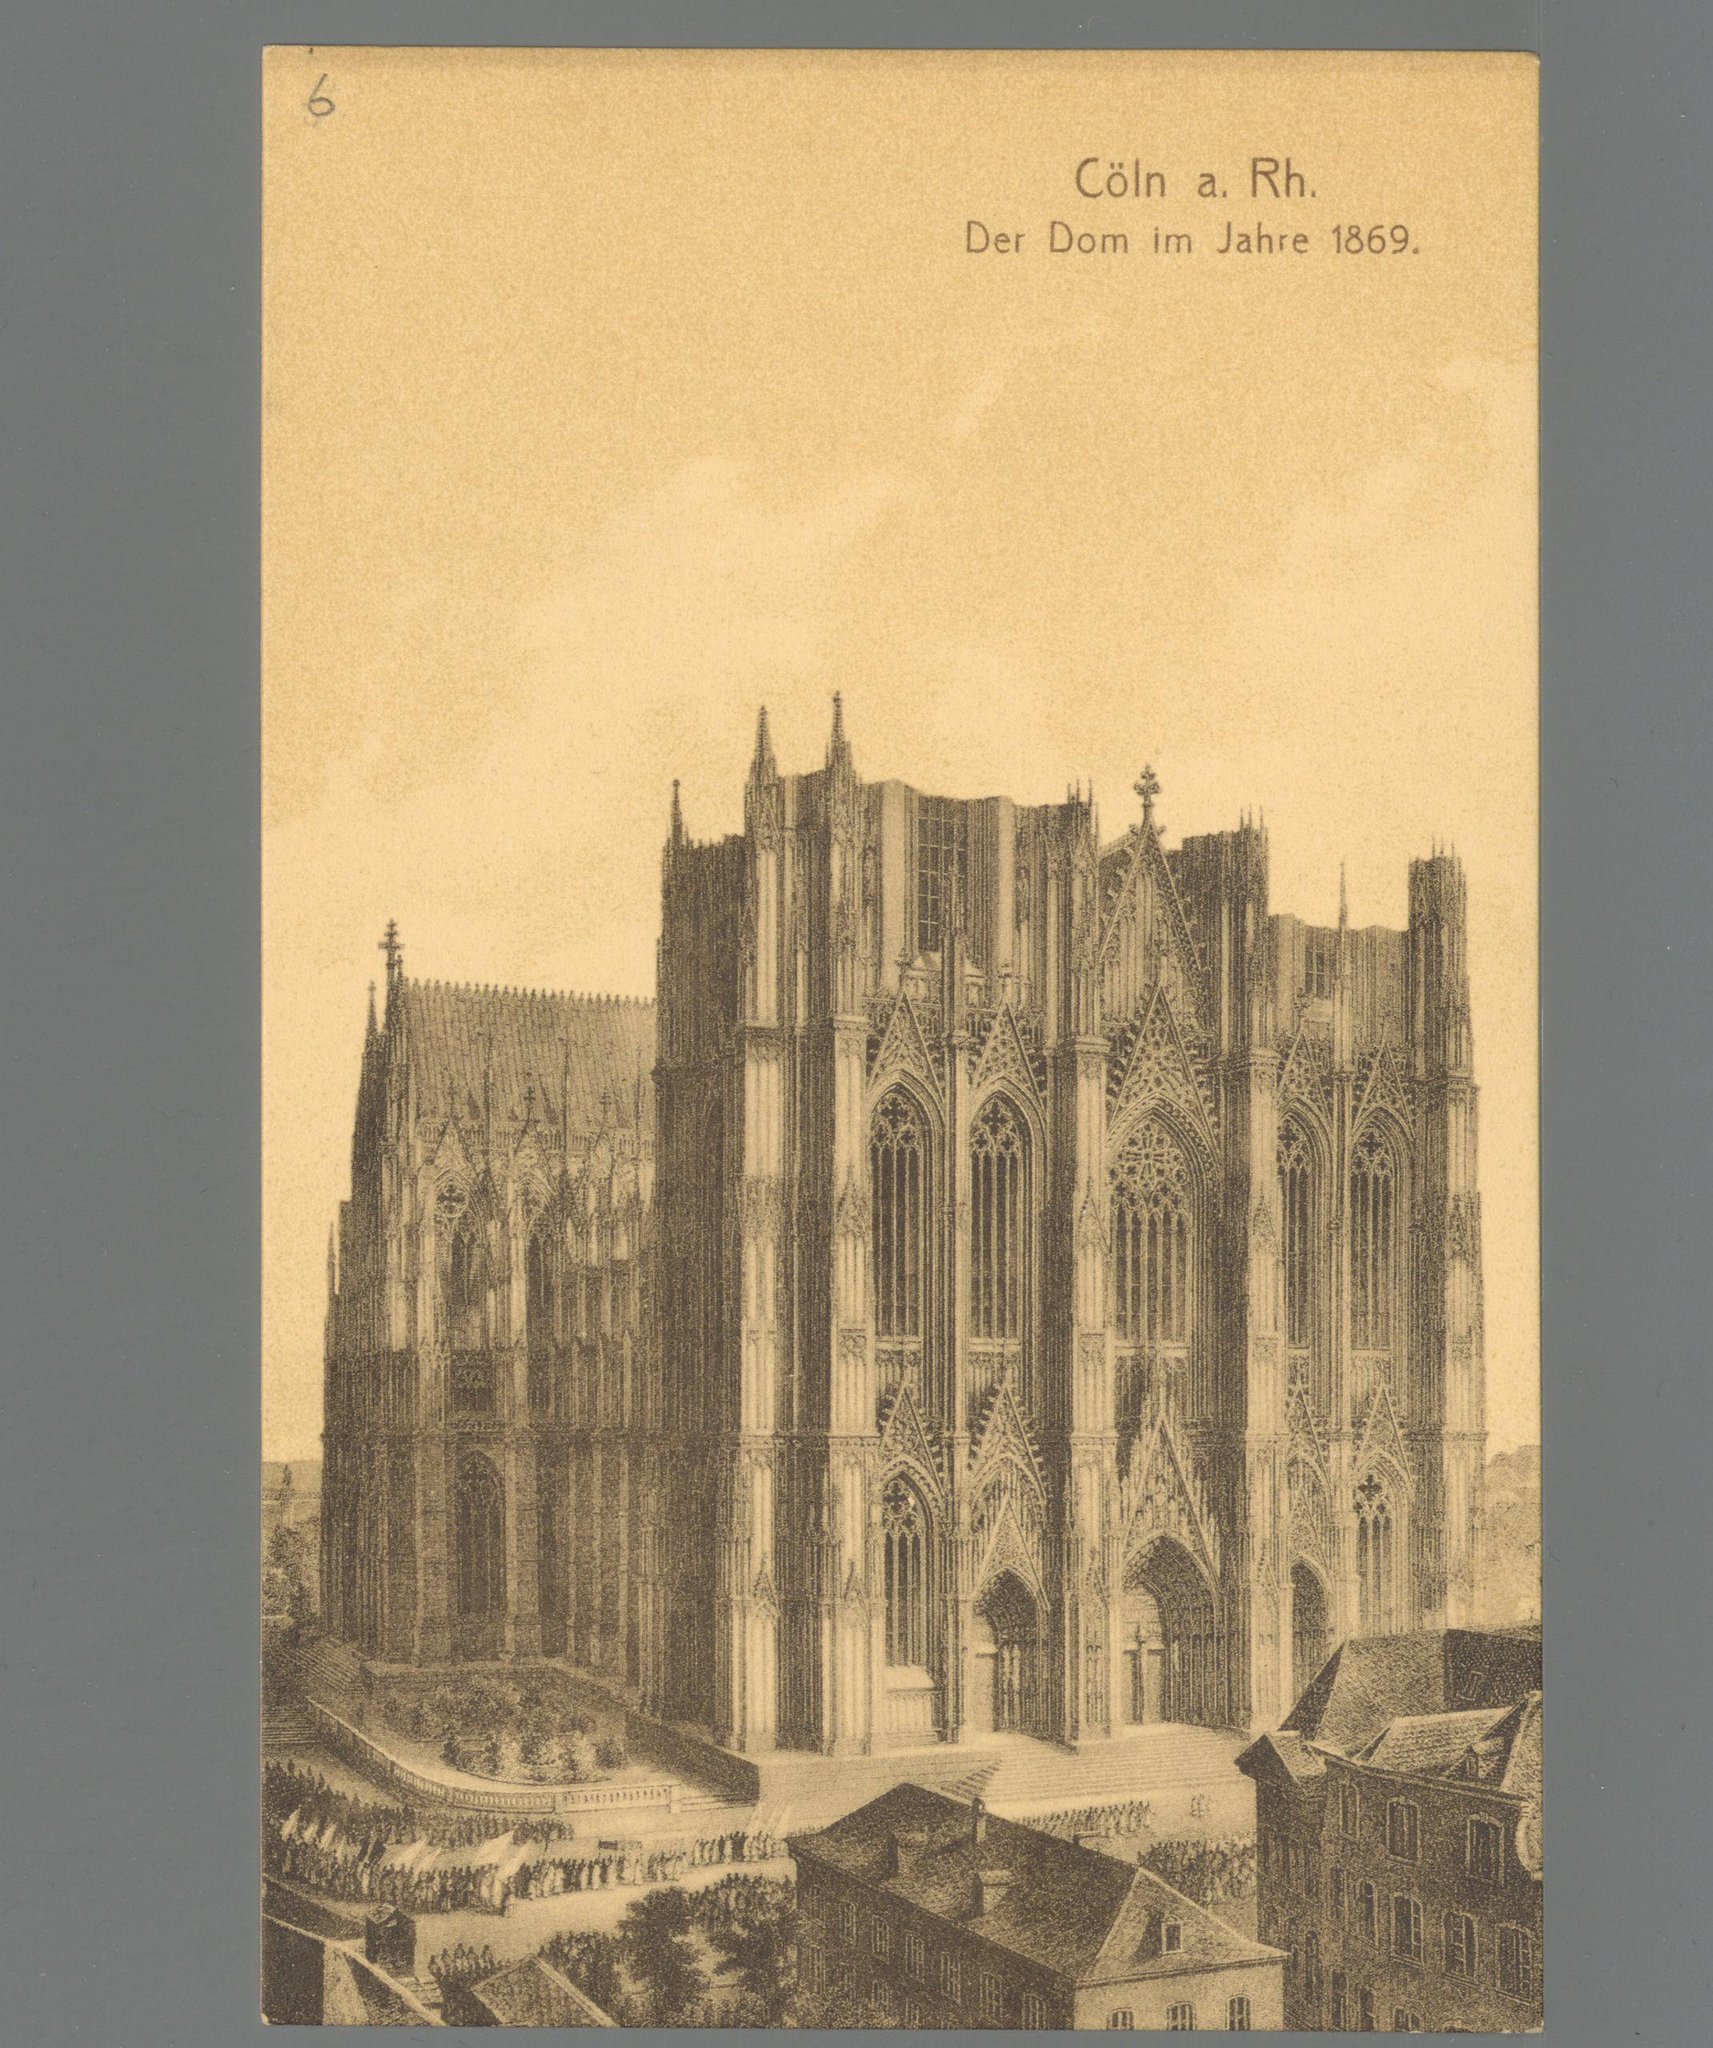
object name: ansichtkaart, prentbriefkaart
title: Cöln a. Rh. Der Dom im Jahre 1869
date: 1905-1930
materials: cardboard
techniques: photograph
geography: mönchengladbach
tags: church (exterior)